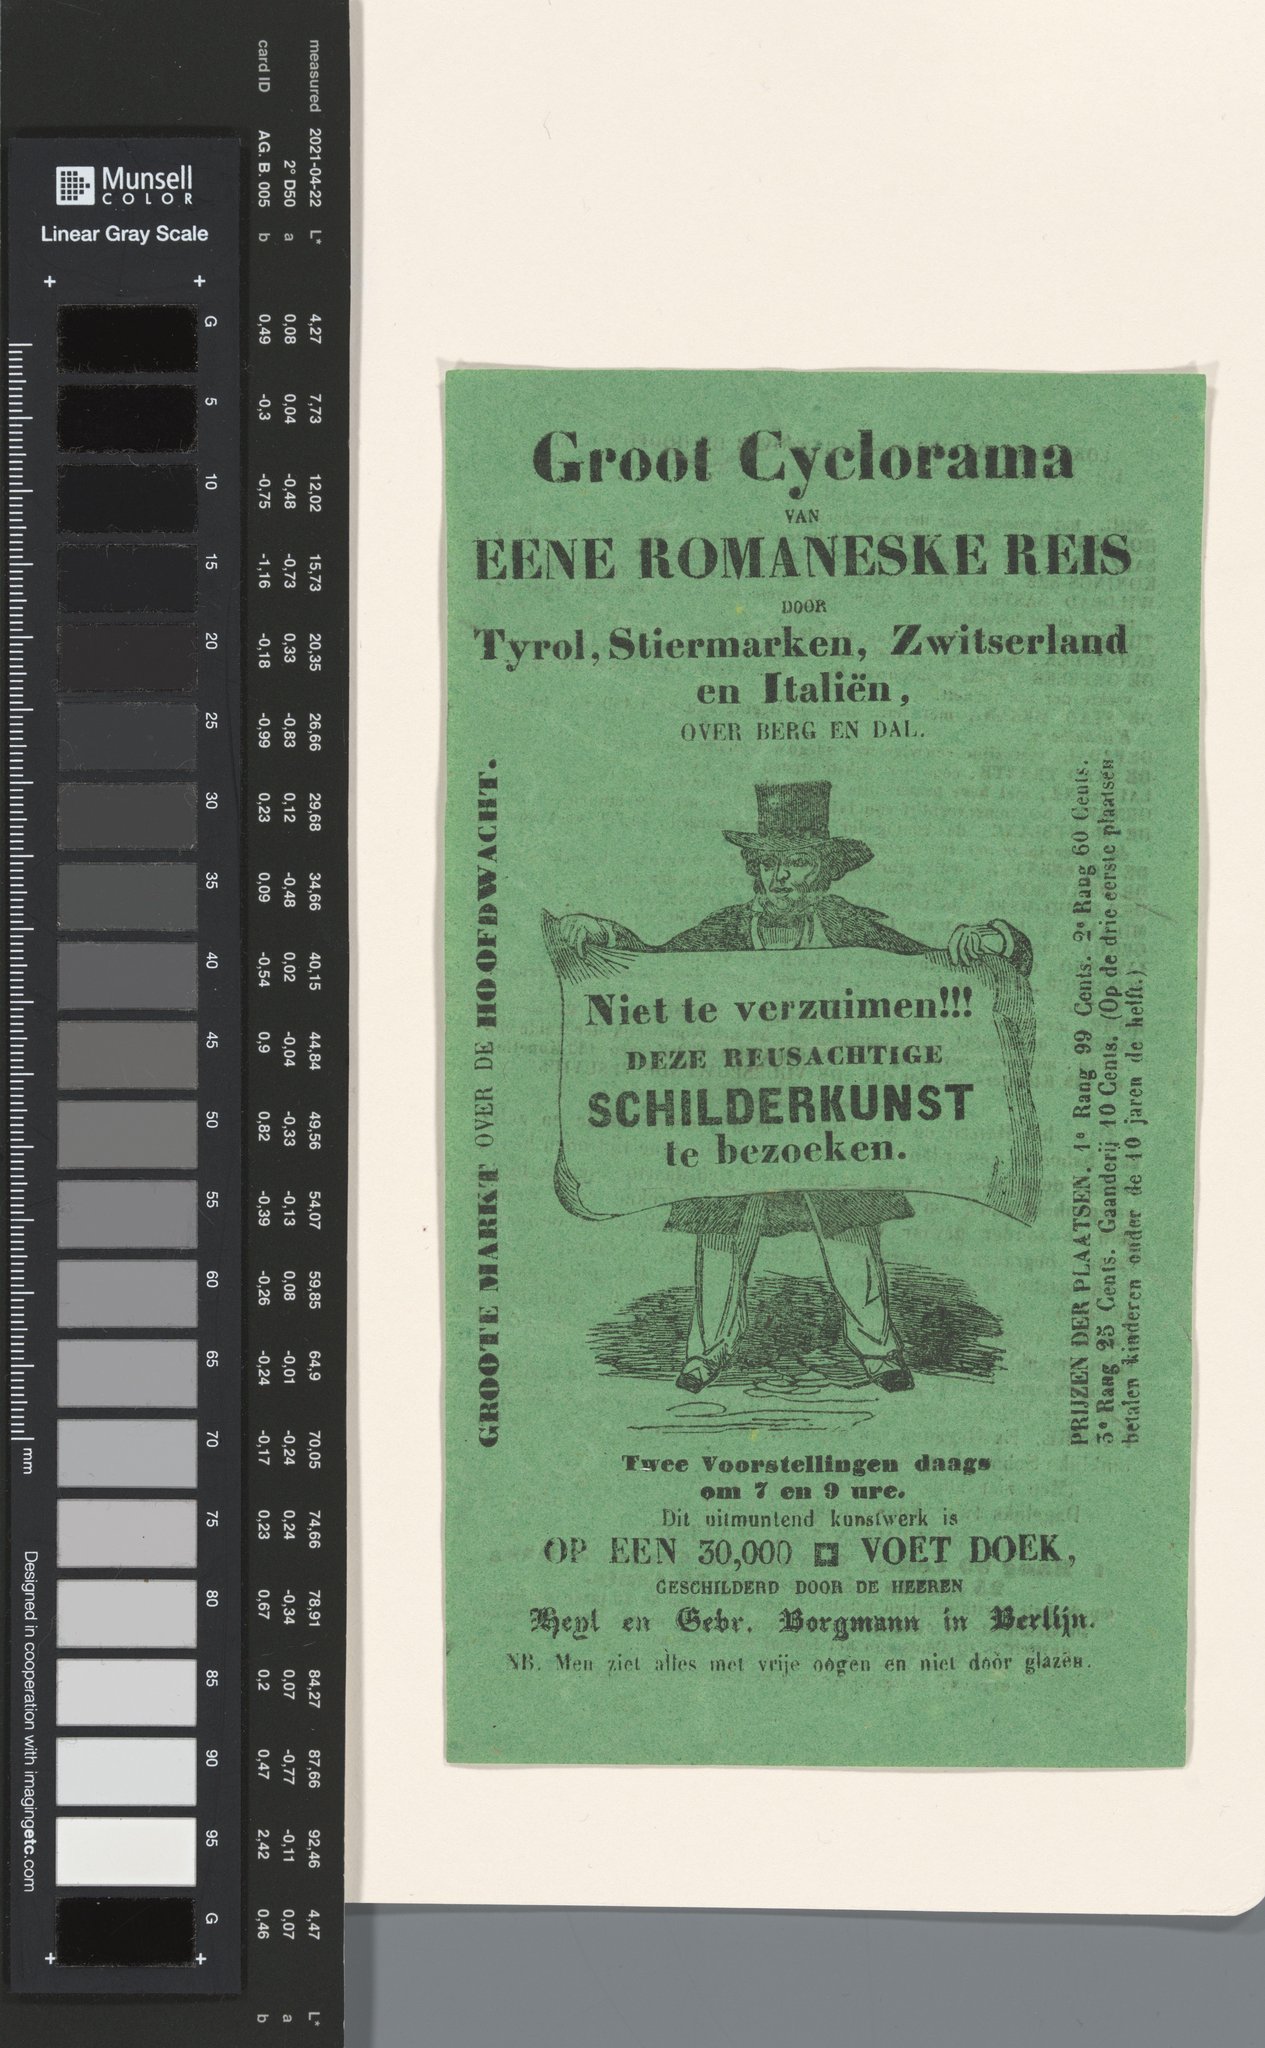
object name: pamphlet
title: Announcement for the ‘Giant Cyclorama’ in Haarlem on the Groote Markt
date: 1853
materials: paper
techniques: letterpress printing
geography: the hague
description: Dit pamflet werd in 1853 in de straten van Haarlem verspreid om de voorstelling van het bewegende panorama van de heer Reichardt op de 'Groote Markt over de Hoofdwacht' aan te kondigen.